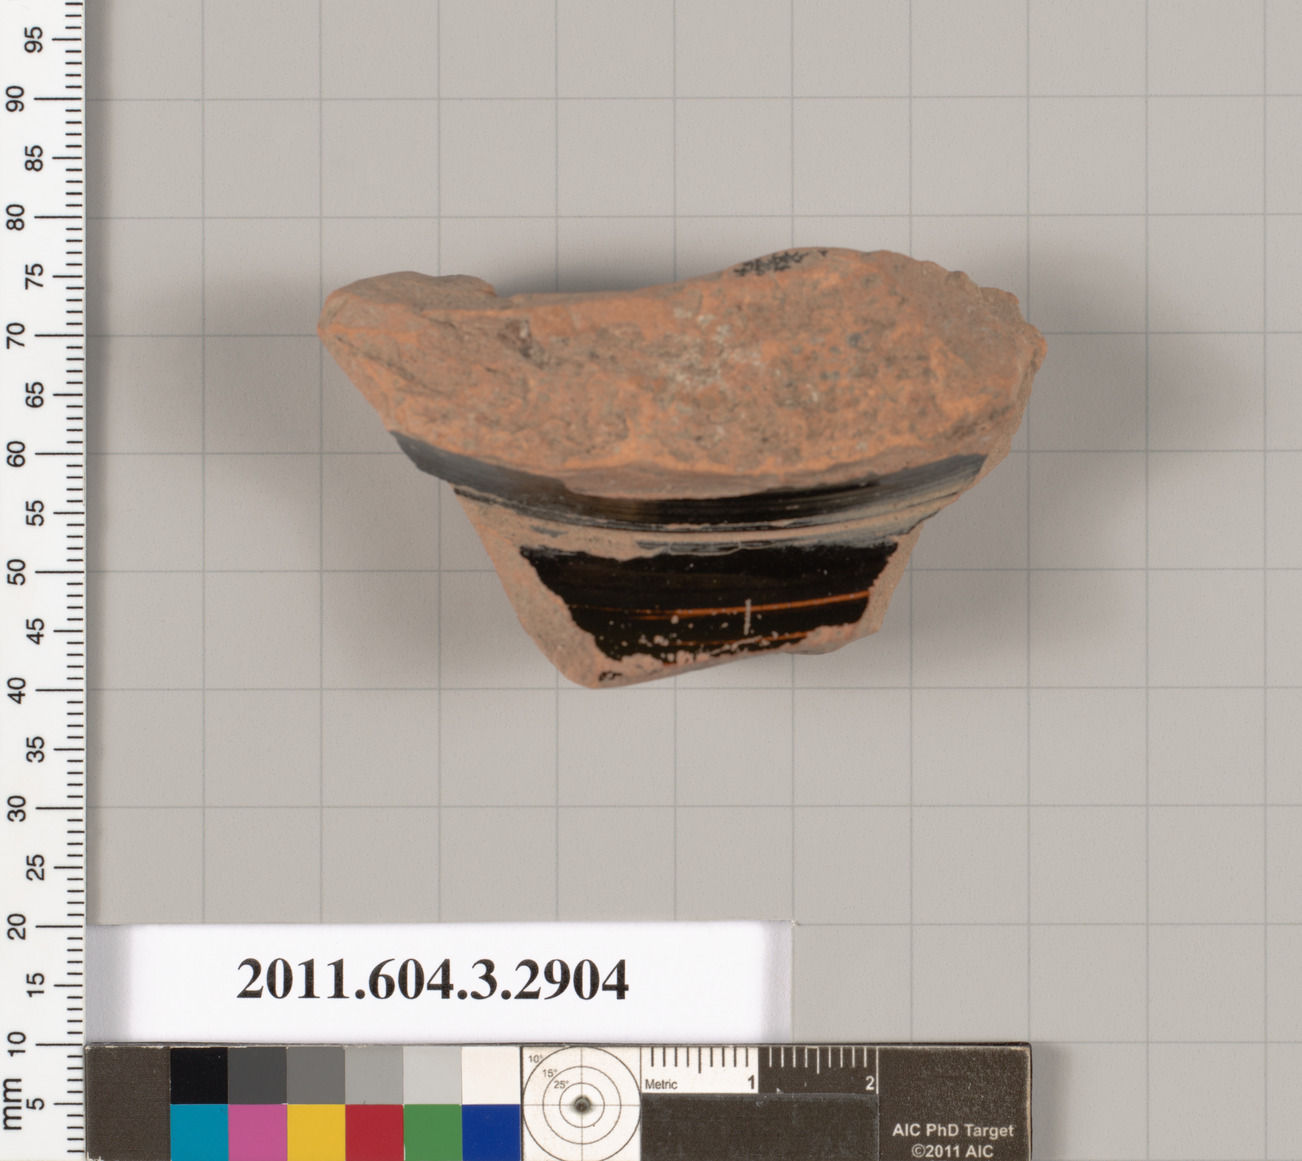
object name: undetermined open vase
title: Terracotta fragment of an open vase?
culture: greek, attic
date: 534-468 BCE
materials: terracotta